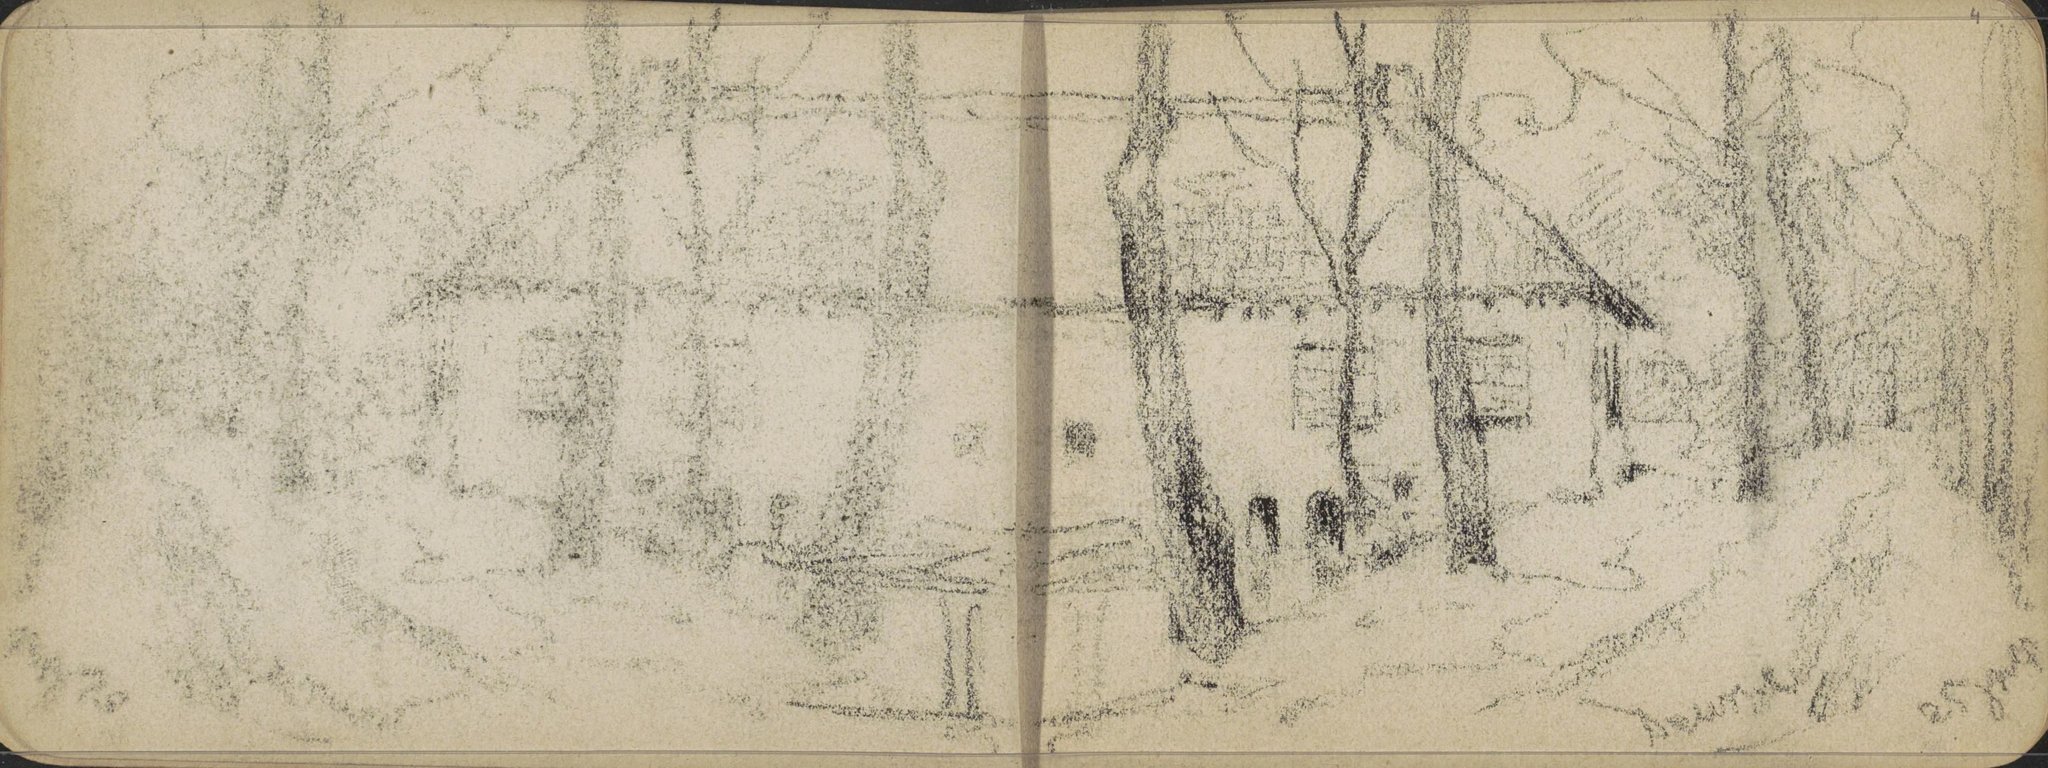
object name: sketchbook leaf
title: Huis langs een bomenlaan te Deurne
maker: willem cornelis rip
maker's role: draughtsman, painter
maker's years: 1856-1922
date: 1807-1897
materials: chalk, paper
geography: deurne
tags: road, path, the usual house or row of houses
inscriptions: date and inscription: ‘Deurne/ 25 July’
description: Blad 3 verso en 4 recto uit een schetsboek met 44 bladen.